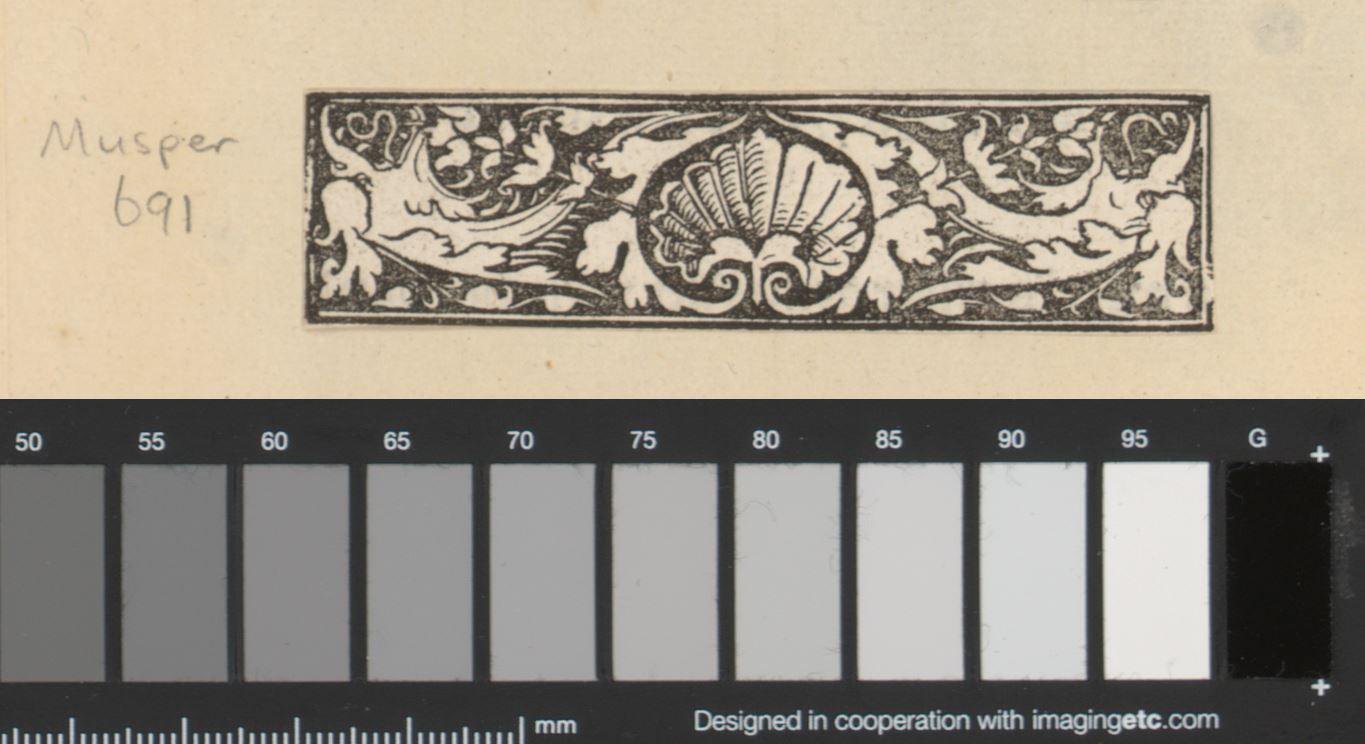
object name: book illustration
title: Schelp en ornamenten met bladmotief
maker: Anonymous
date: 1514-1532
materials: paper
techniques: letterpress printing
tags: foliage ~ ornament, scallop, shell ~ ornament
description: Deze prent is gebruikt als ornament in: Petrarca, Francesco. Von der Artzney bayder Glück, des guten und widerwertigen: unnd weß sich ain yeder inn Gelück und Unglück halten sol (...). Augsburg: Heinrich Steiner, 1532. Deze uitgave is ook bekend onder de titel 'Trostspiegel in Glück und Unglück'.